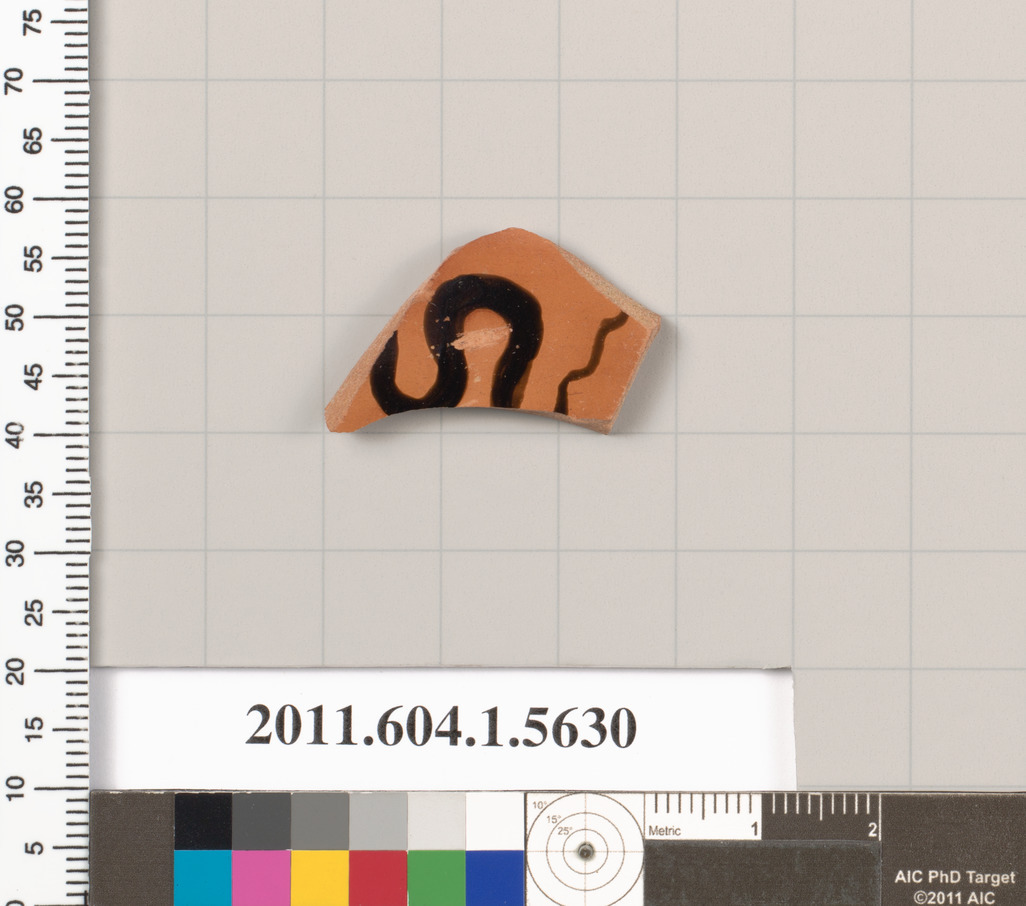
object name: kylix fragment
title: Terracotta fragment of a kylix (drinking cup)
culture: greek, attic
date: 510-500 BCE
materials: terracotta